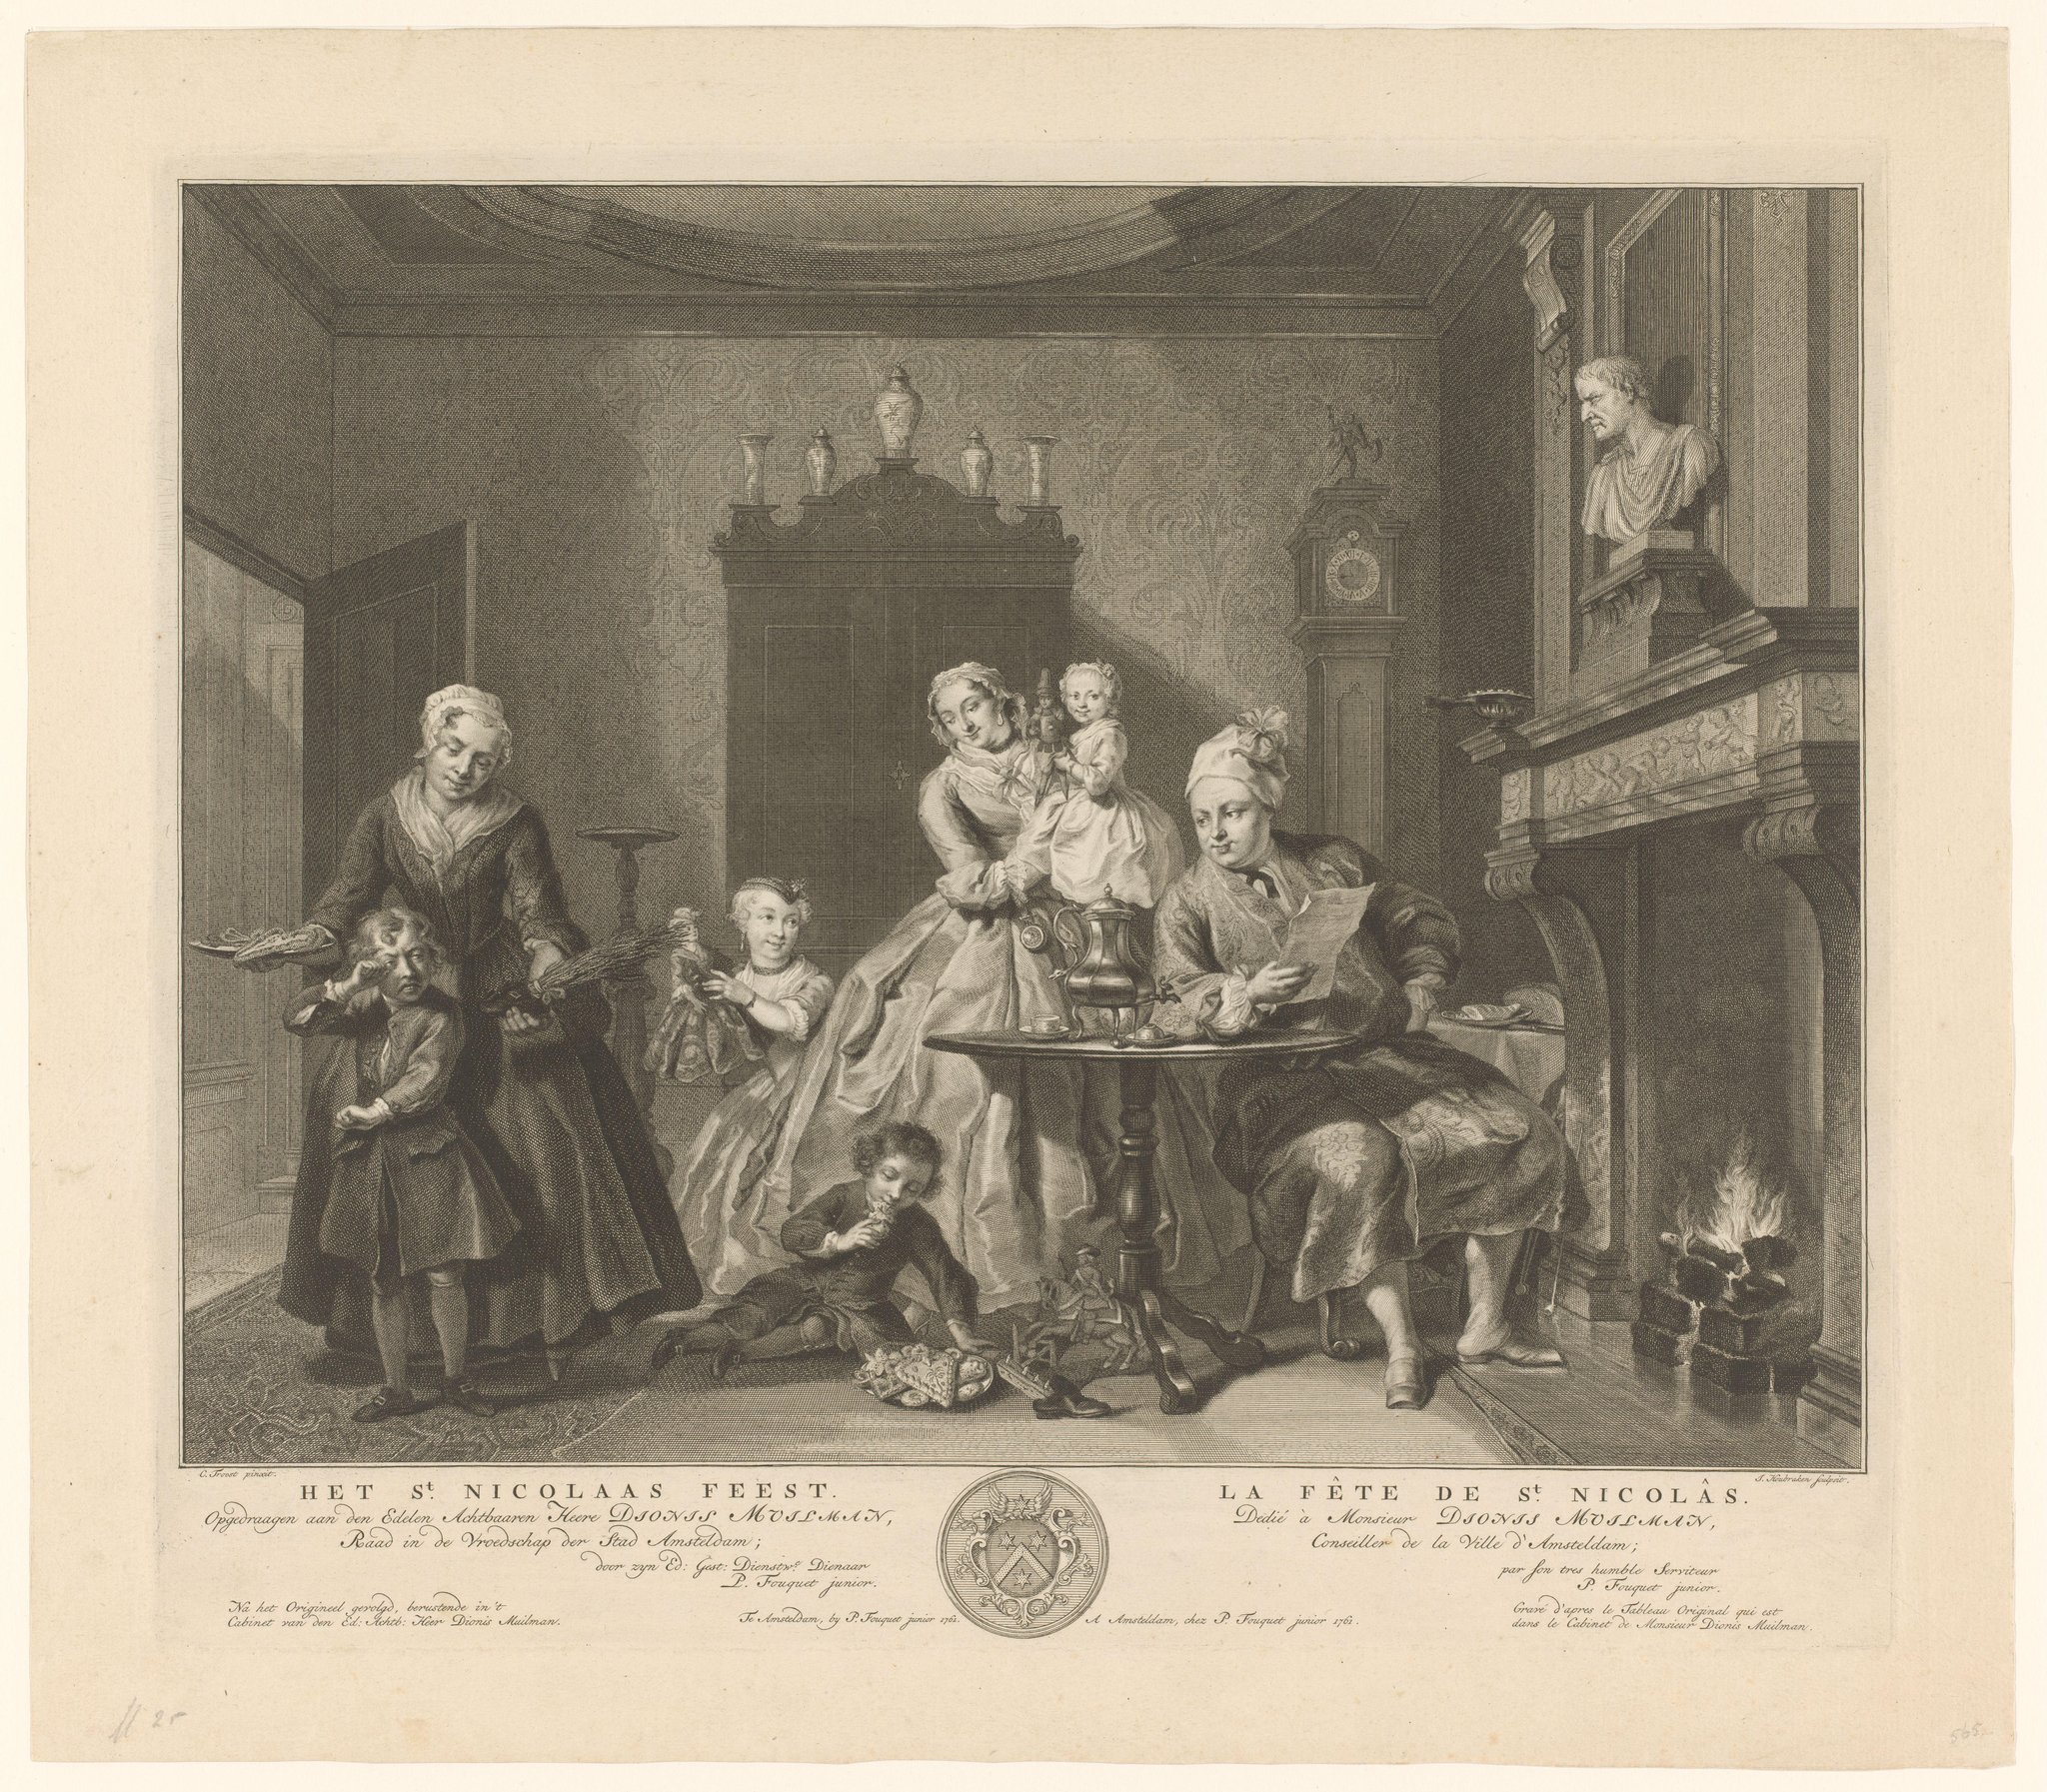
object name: print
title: Het St. Nicolaas feest/ La fête de St. Nicolâs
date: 1761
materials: paper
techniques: engraving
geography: amsterdam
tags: parents with their children, cake, tart, pastry, open hearth, fire-place, (playing with) dolls, festivities on st. nicholas (eve) (december 5)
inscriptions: collector's mark: Lugt 2233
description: In een interieur viert een gezin het Sint Nicolaasfeest. De vader zit bij de haard te lezen, achter hem laten twee dochters hun poppen zien die ze hebben gekregen. Op de grond snoept een kind met een schaal met koek en snoepgoed. Links een huilende jongen die alleen een roe heeft gekregen; de dienstmeid achter hem heeft zijn schoen met daarin de roe vast.